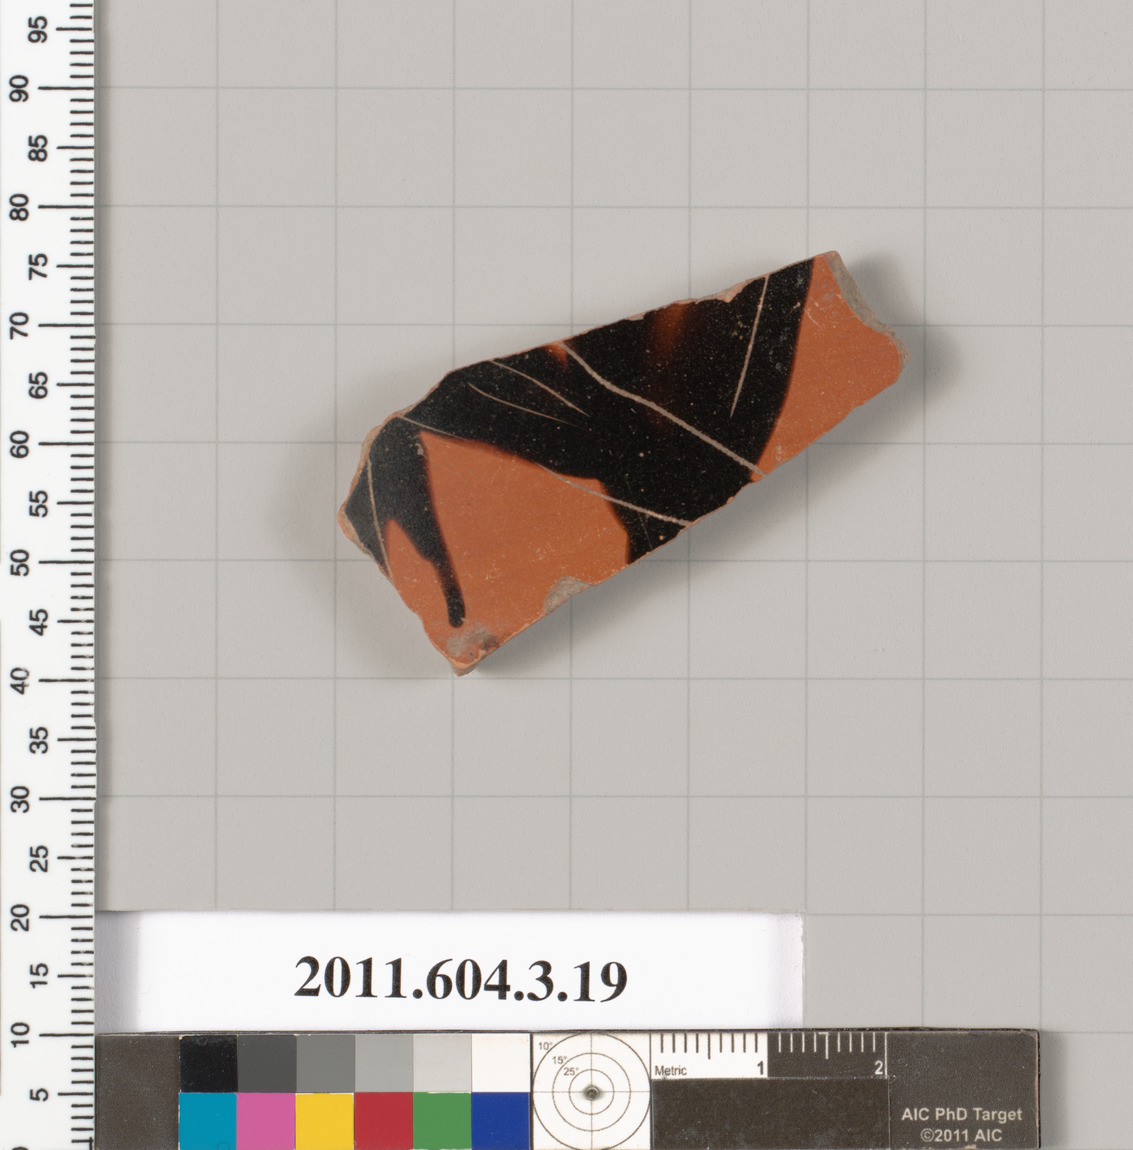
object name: neck amphora fragment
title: Terracotta fragment of a neck-amphora (jar)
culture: greek, attic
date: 550-501 BCE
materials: terracotta